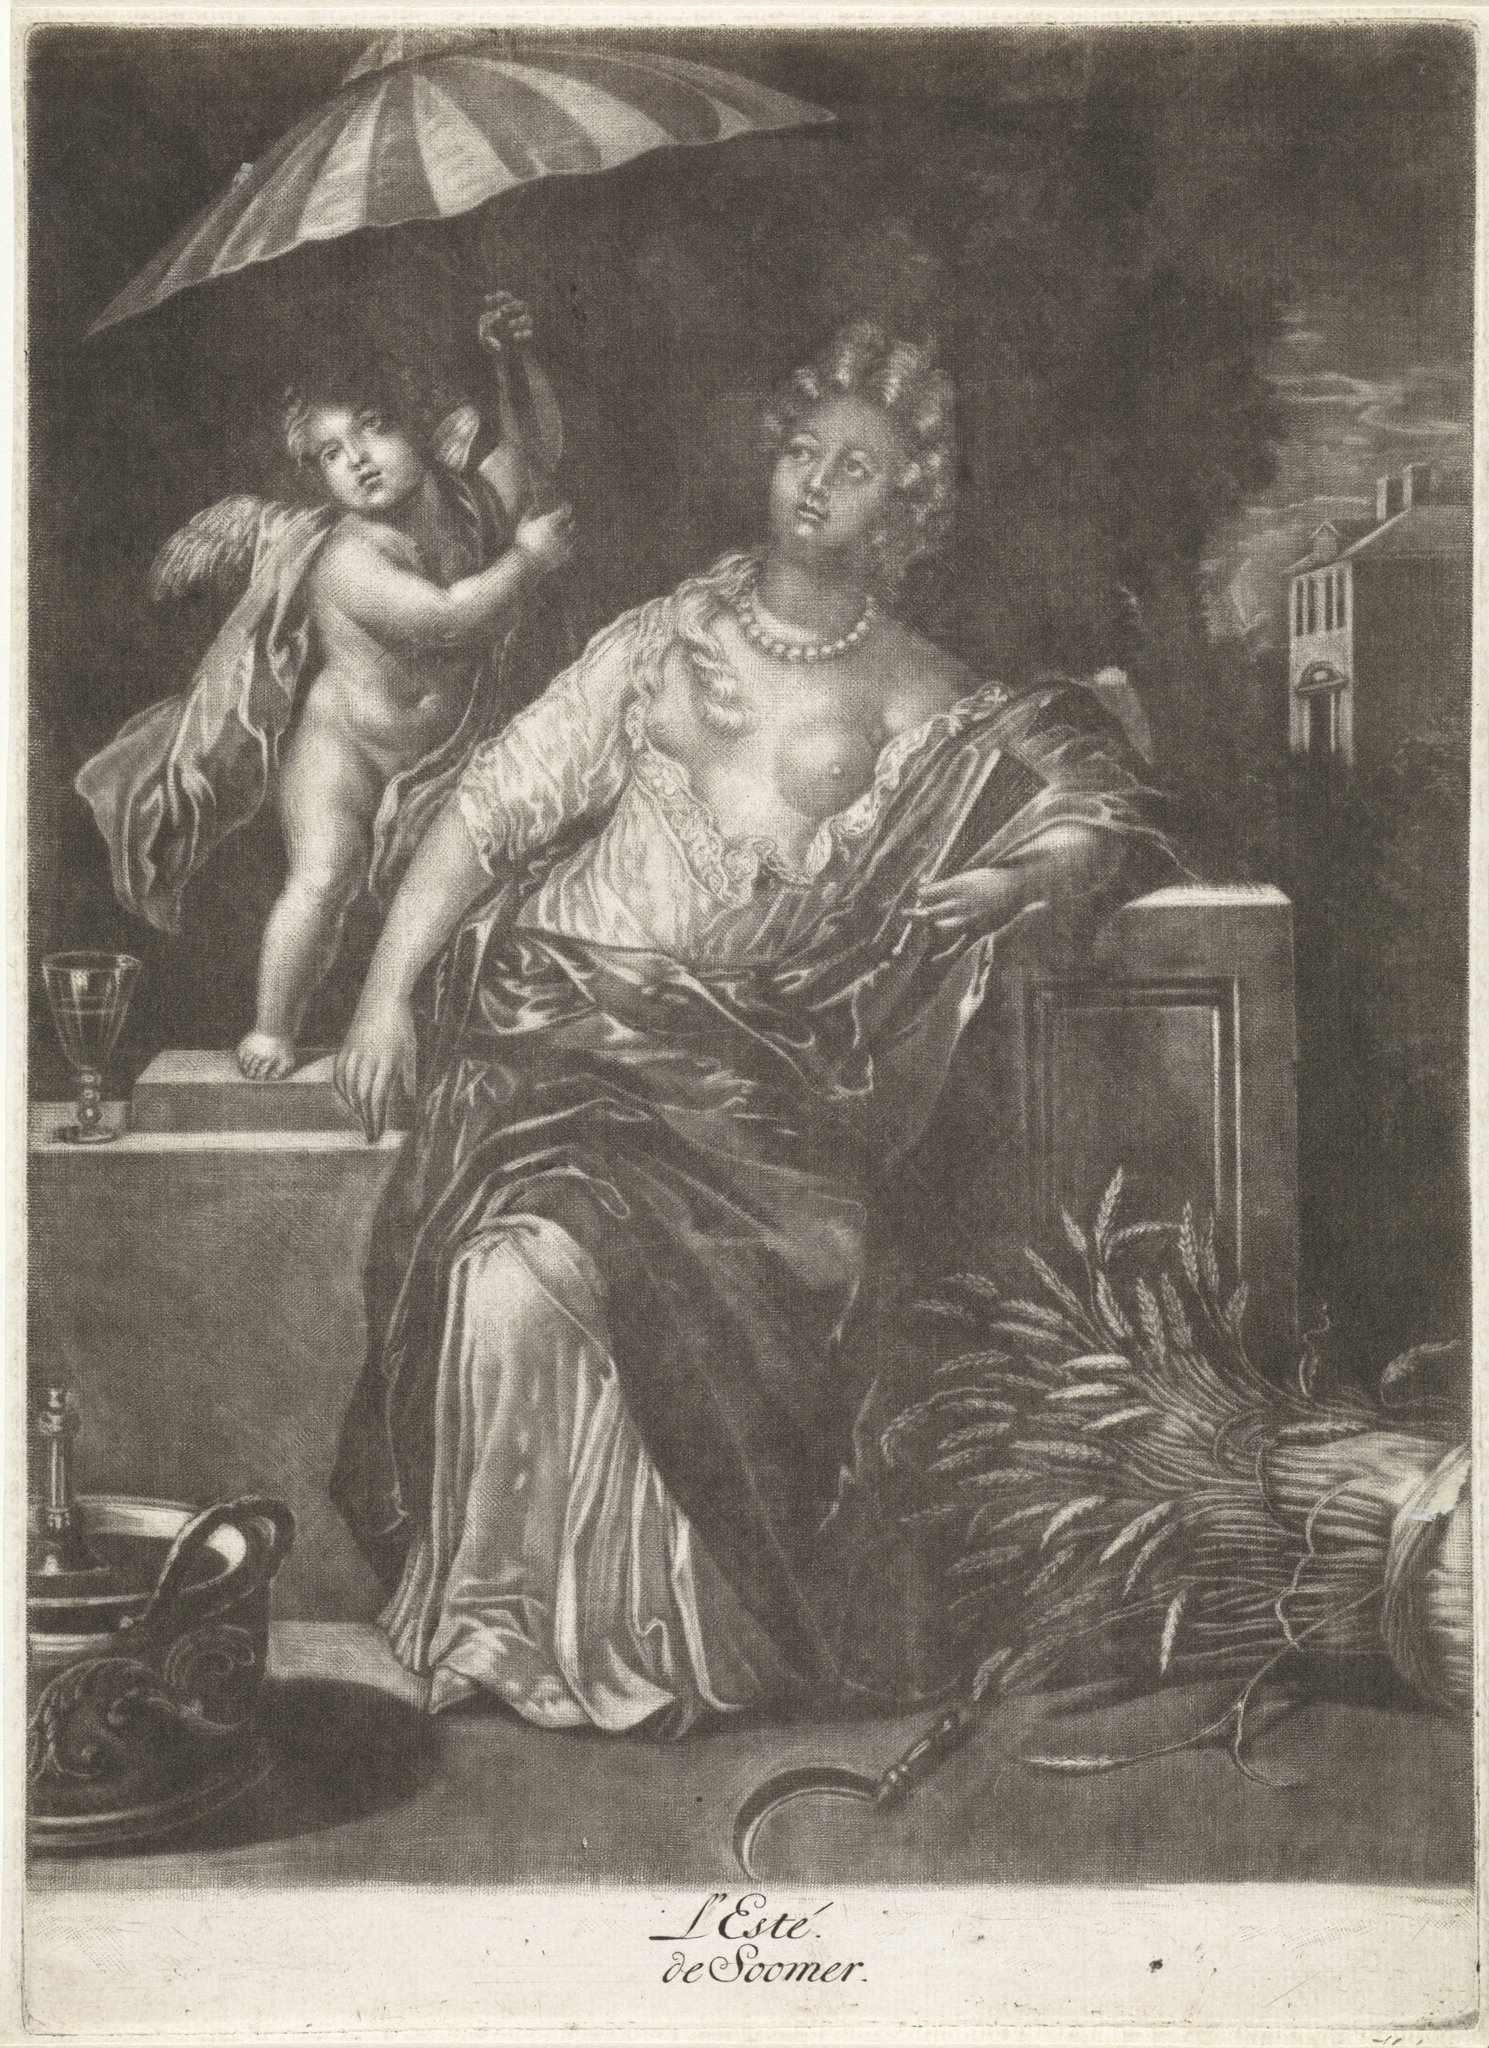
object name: print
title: L'Esté /de Soomer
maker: Anonymous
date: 1690-1750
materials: paper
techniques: engraving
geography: netherlands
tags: vine, summer, 'aestas'; 'estate' (ripa), agricultural implements: sickle, parasol, sunshade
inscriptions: collector's mark: Lugt 2228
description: Allegorische voorstelling van de Zomer. Een vrouw met ontblote boezem zit op een bank in de schaduw van de parasol die een putto voor haar op houdt. Op de grond liggen een bundel koren en een sikkel en op de bank staat een glas met wijn.